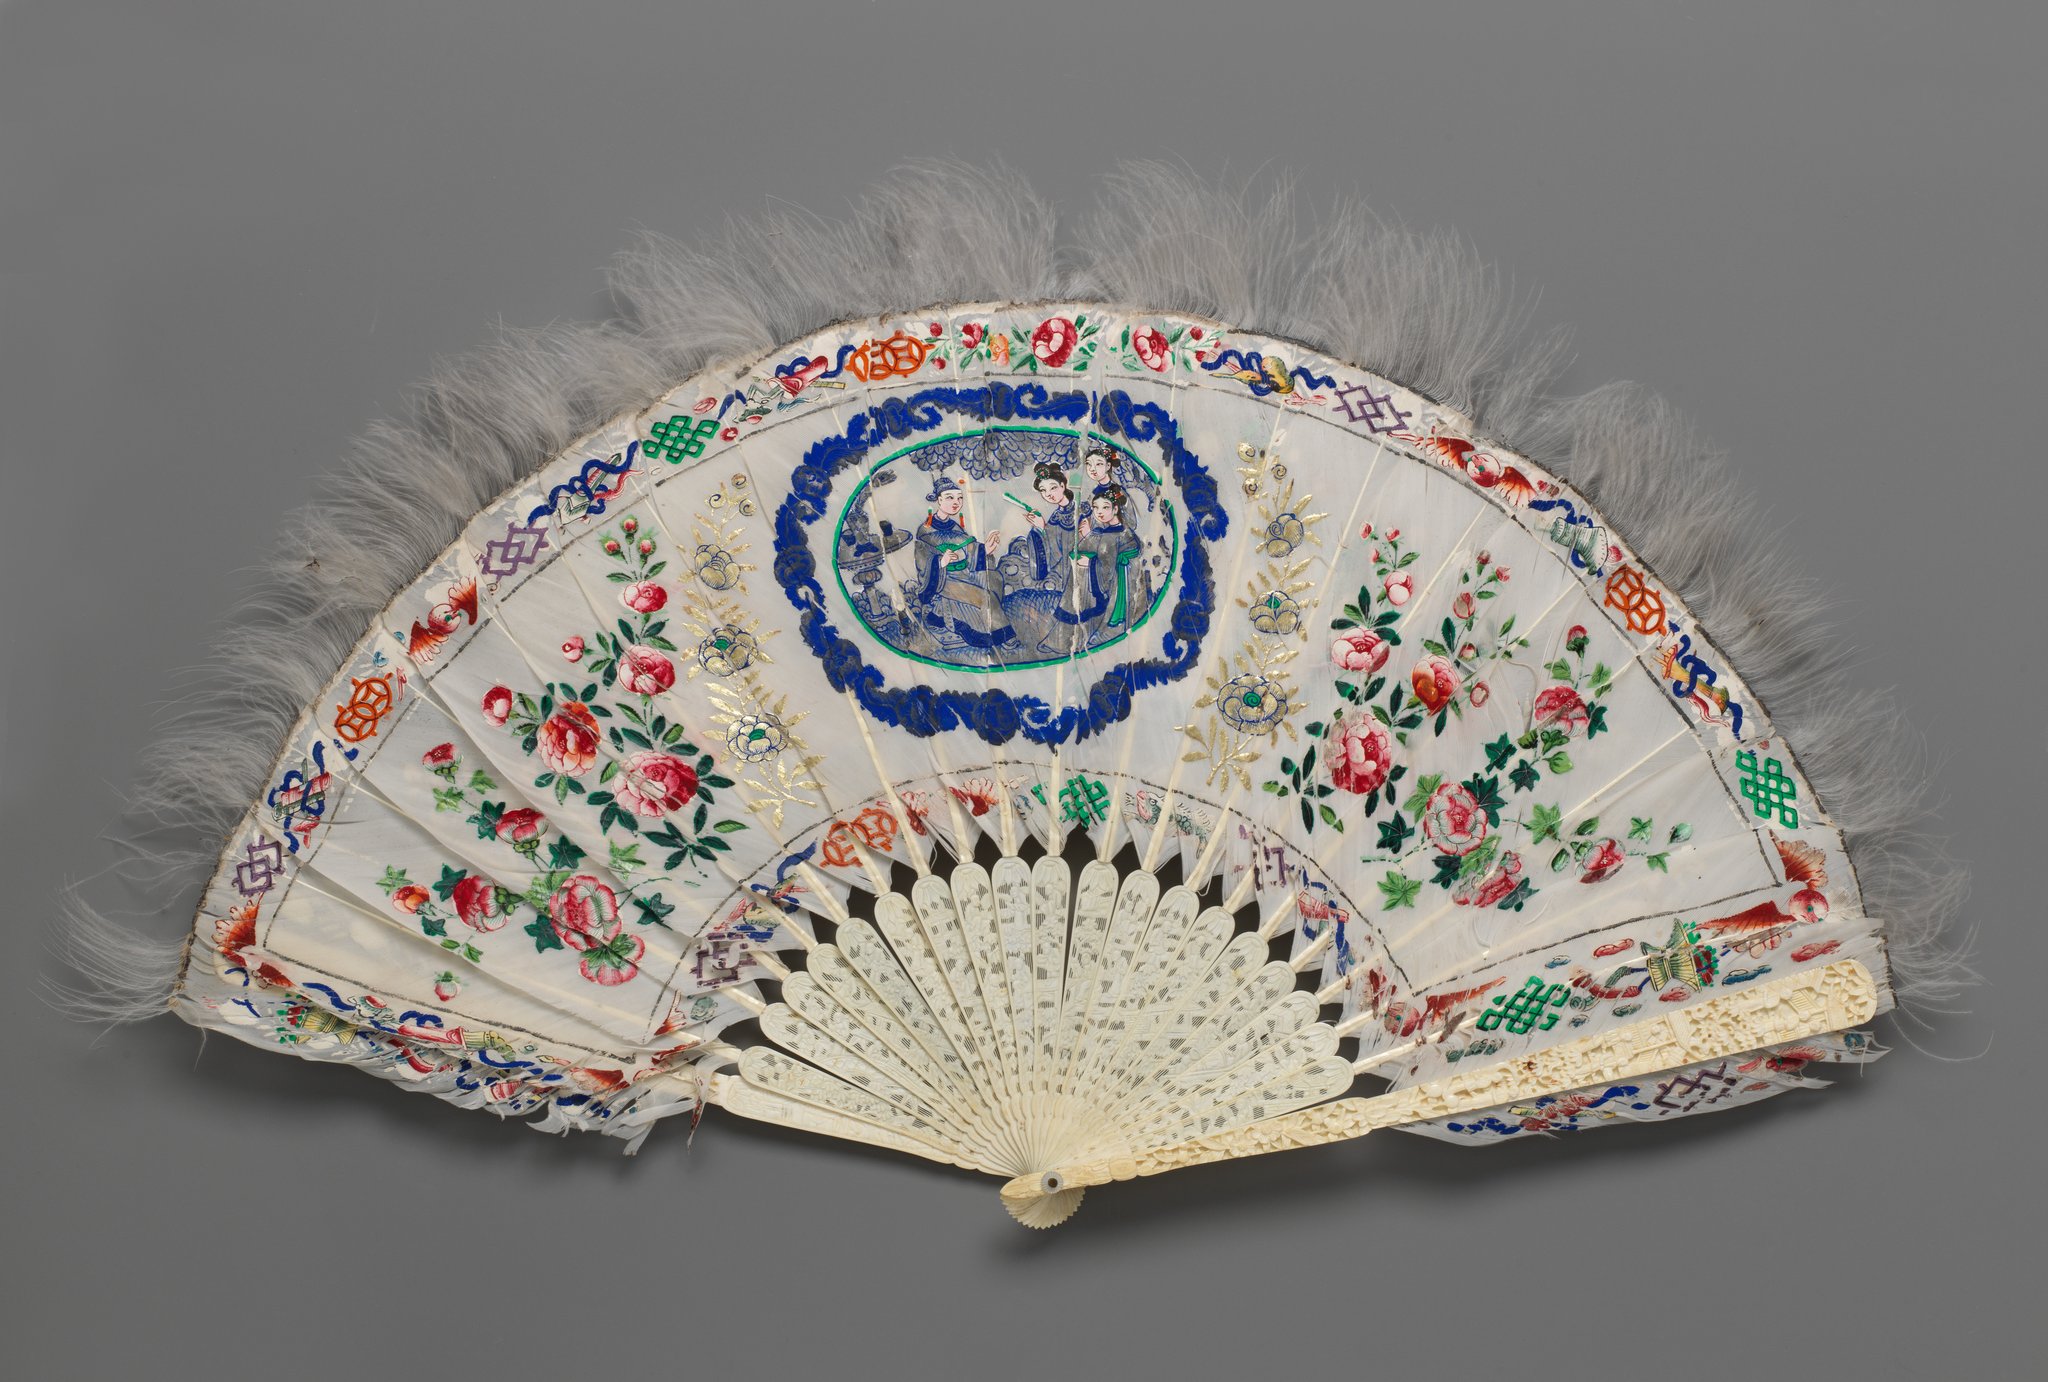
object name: fan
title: Folding Fan with Ladies in a Garden, flanked by Flowers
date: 1801-1850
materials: feather, ivory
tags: women,flowers